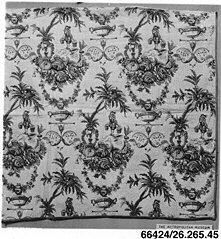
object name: furnishing textile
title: Pictorial print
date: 1785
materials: linen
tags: human figures,flowers